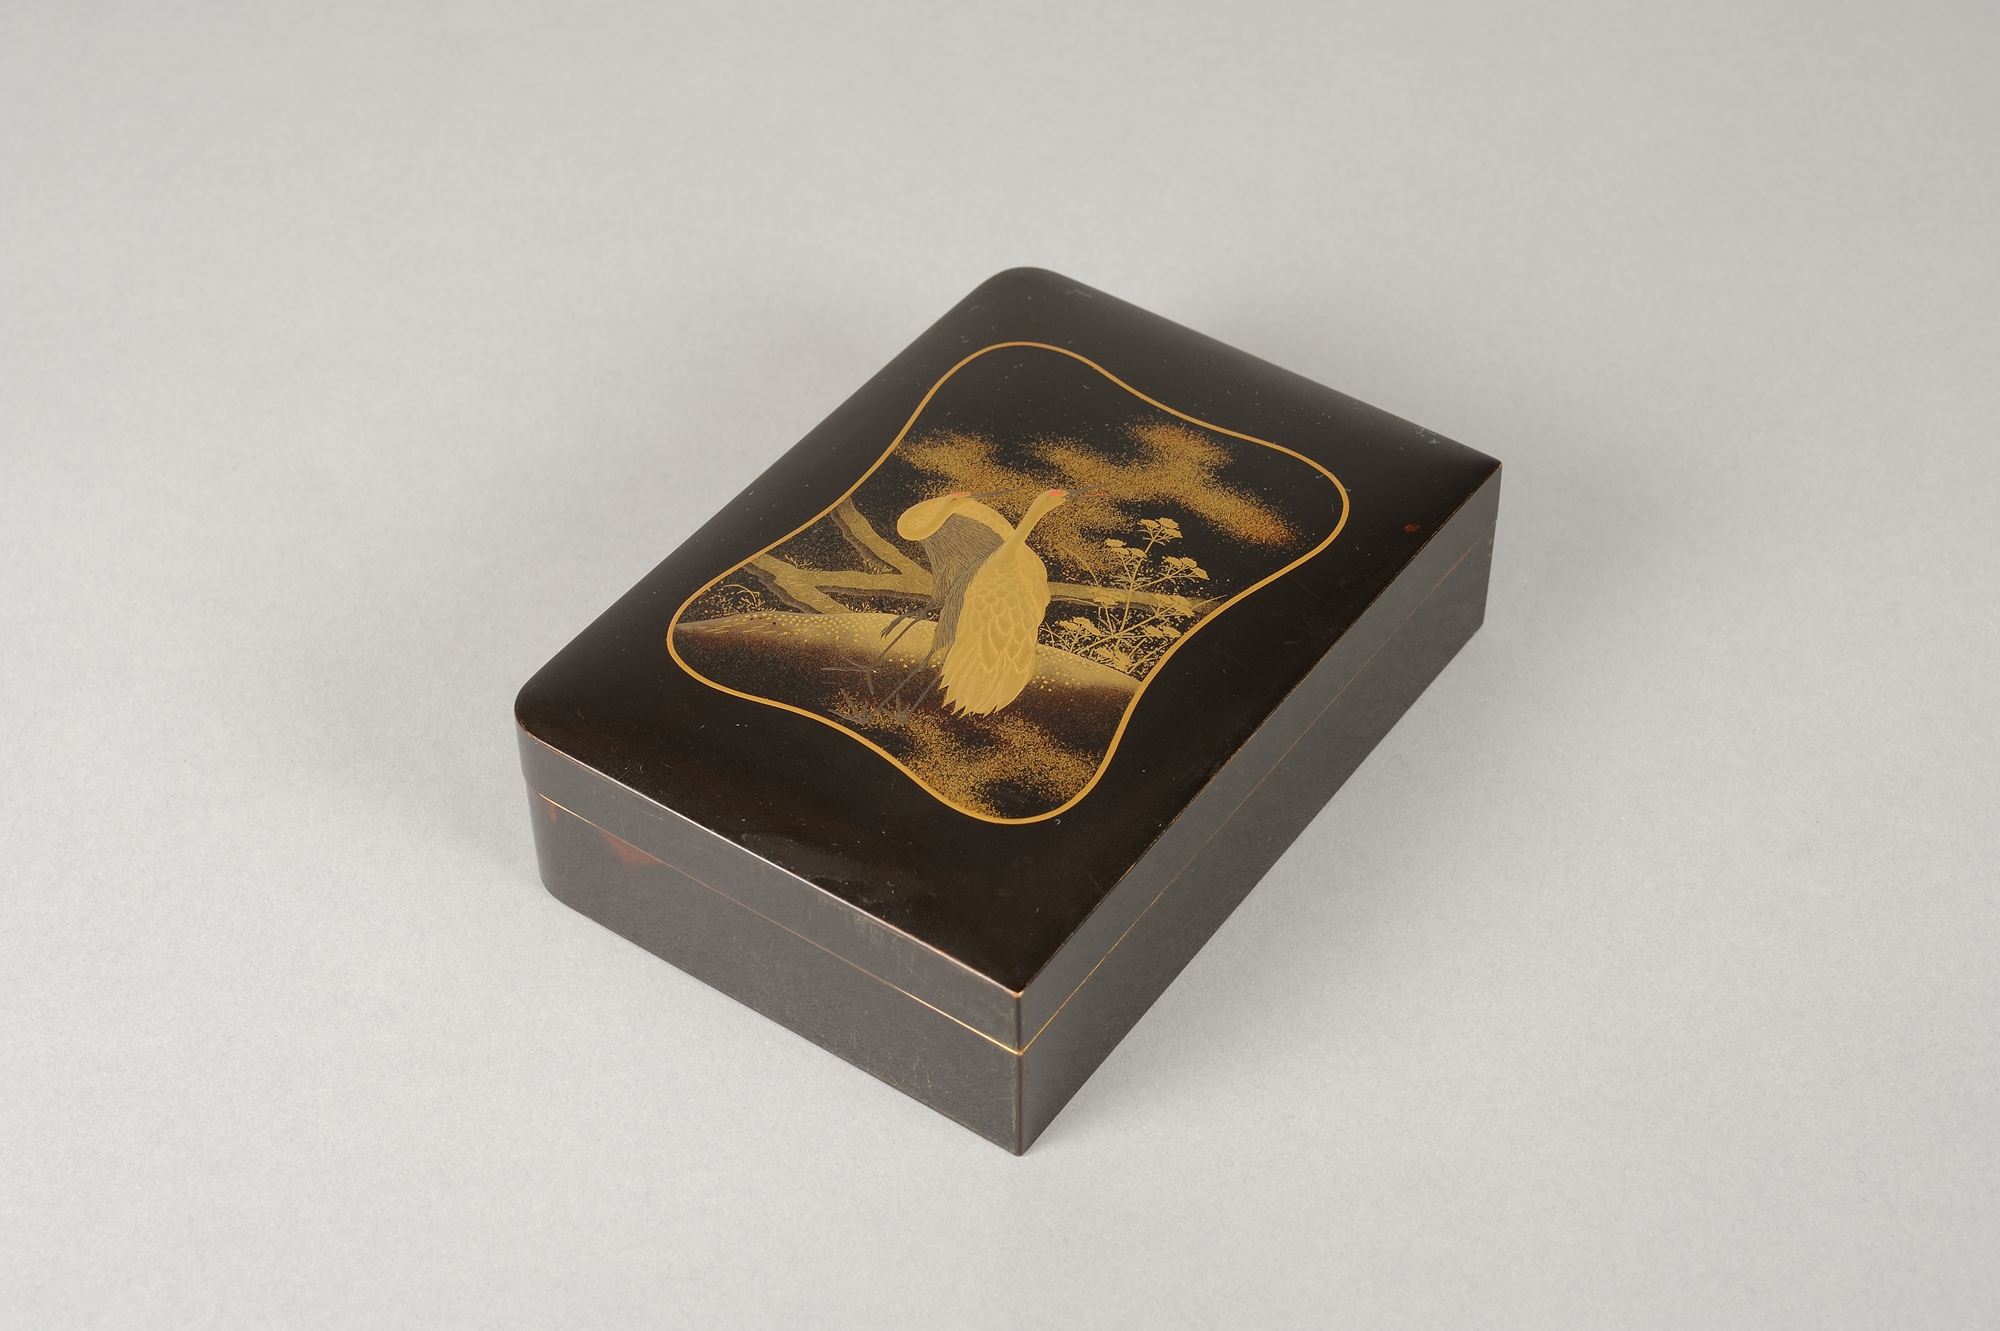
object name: box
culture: japanese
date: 1801-1900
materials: lacquer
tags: birds